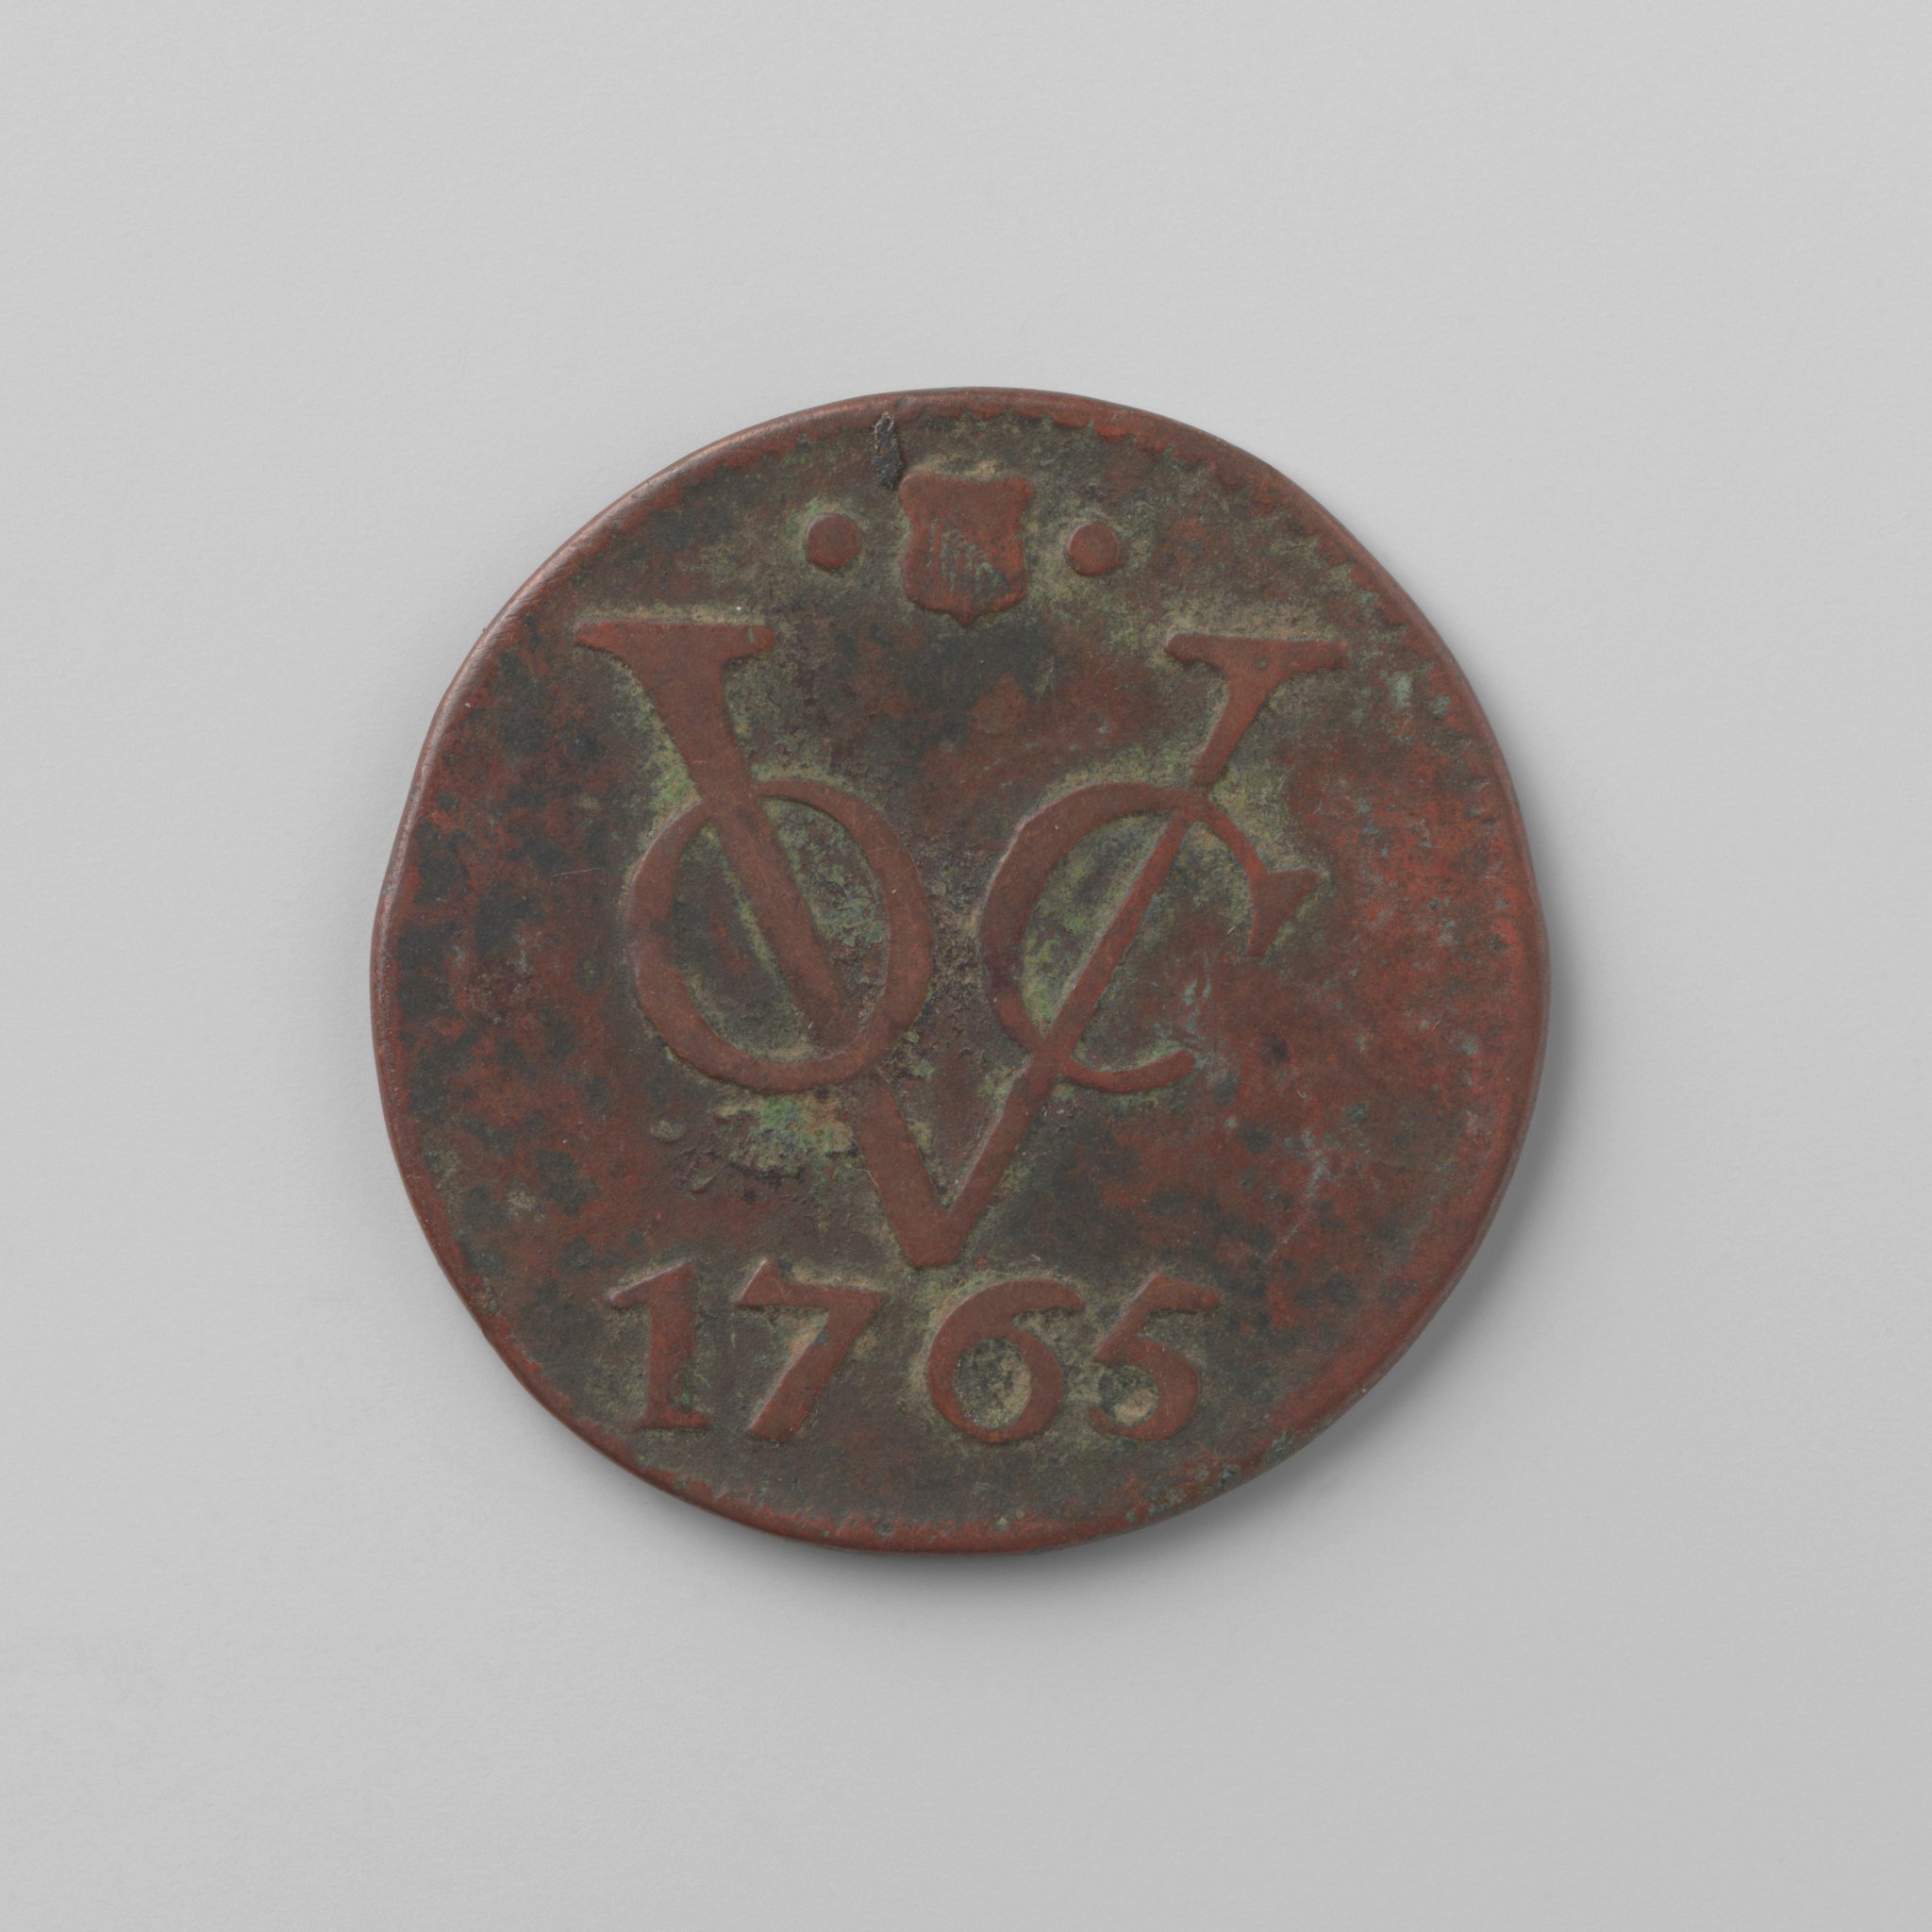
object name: coin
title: Duit van de VOC uit de stad Utrecht,1765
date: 1765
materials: copper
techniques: striking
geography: utrecht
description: Koperen munt. Voorzijde: op balk, waaronder guirlande, geplaatst, door twee leeuwen gehouden gekroond wapenschild van de stad Utrecht. Keerzijde: monogram van de VOC, waarboven muntteken en waaronder jaartal. Gladde rand.